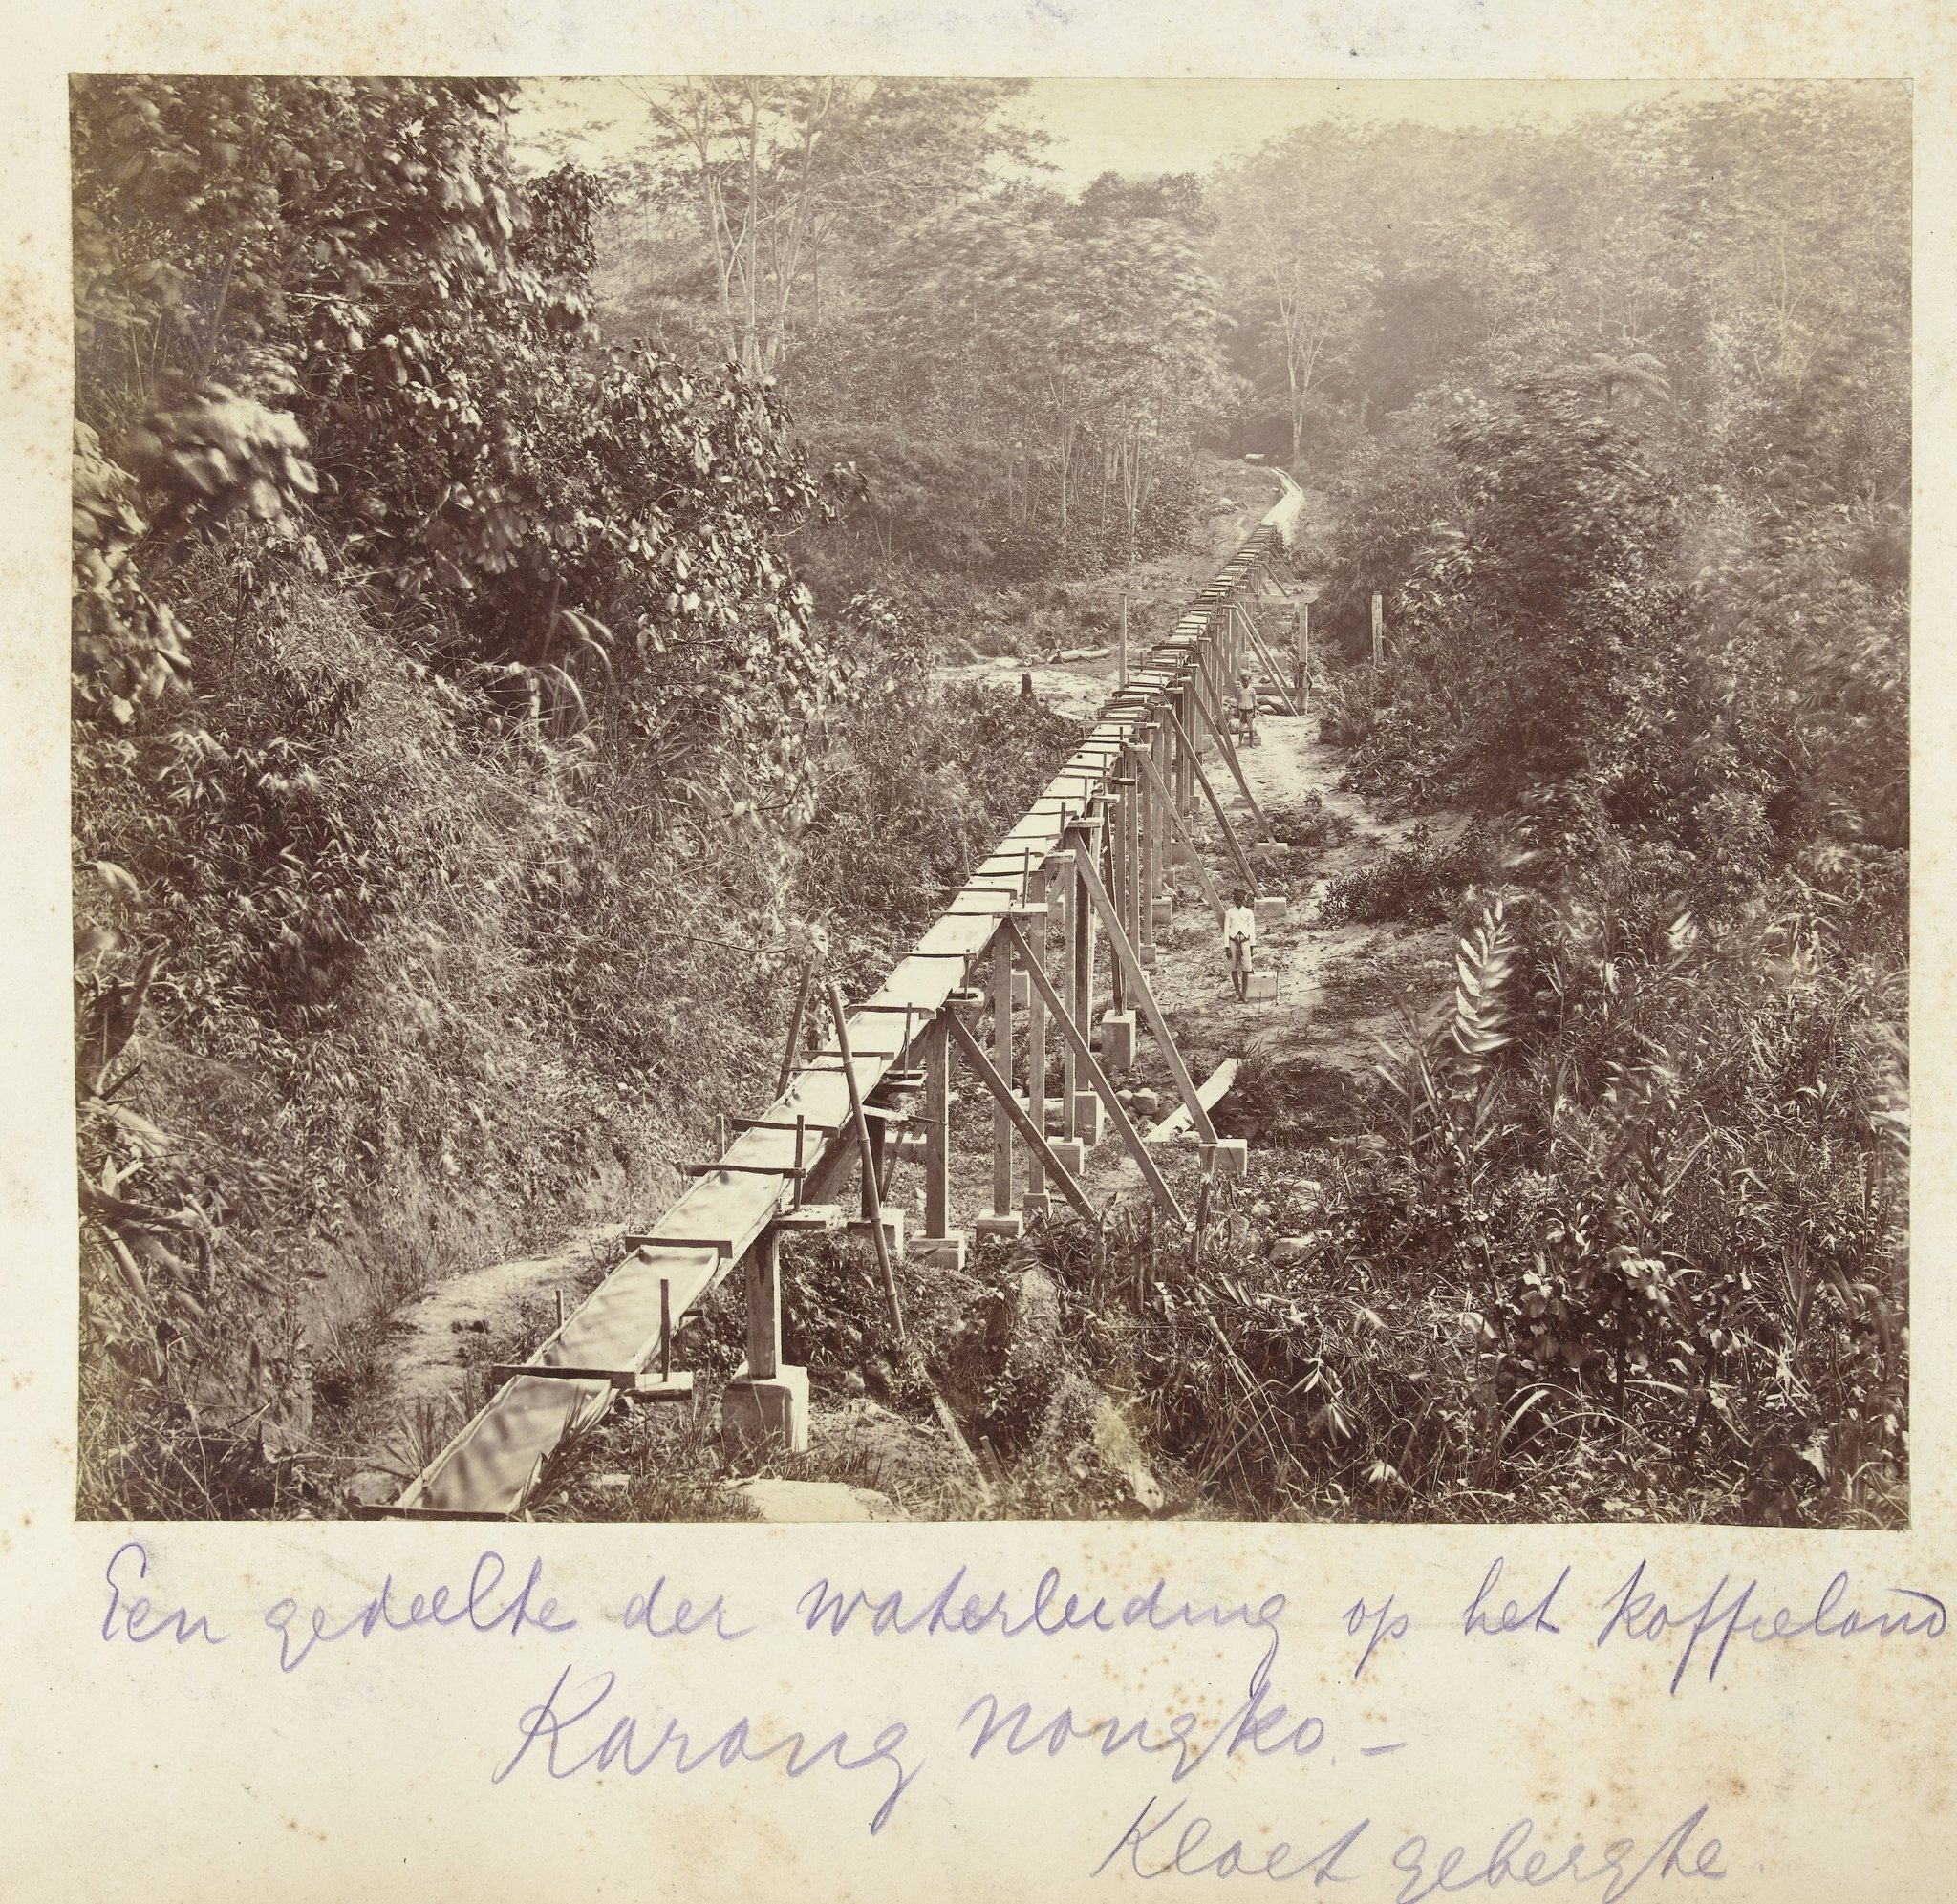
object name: photograph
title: Een gedeelte der waterleiding op het koffieland Karang Nangko.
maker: Anonymous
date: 1890-1910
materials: cardboard, paper, photographic support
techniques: gelatin silver print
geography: singapore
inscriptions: caption: ‘Een gedeelte der waterleiding op het koffieland Karang Nangko.’